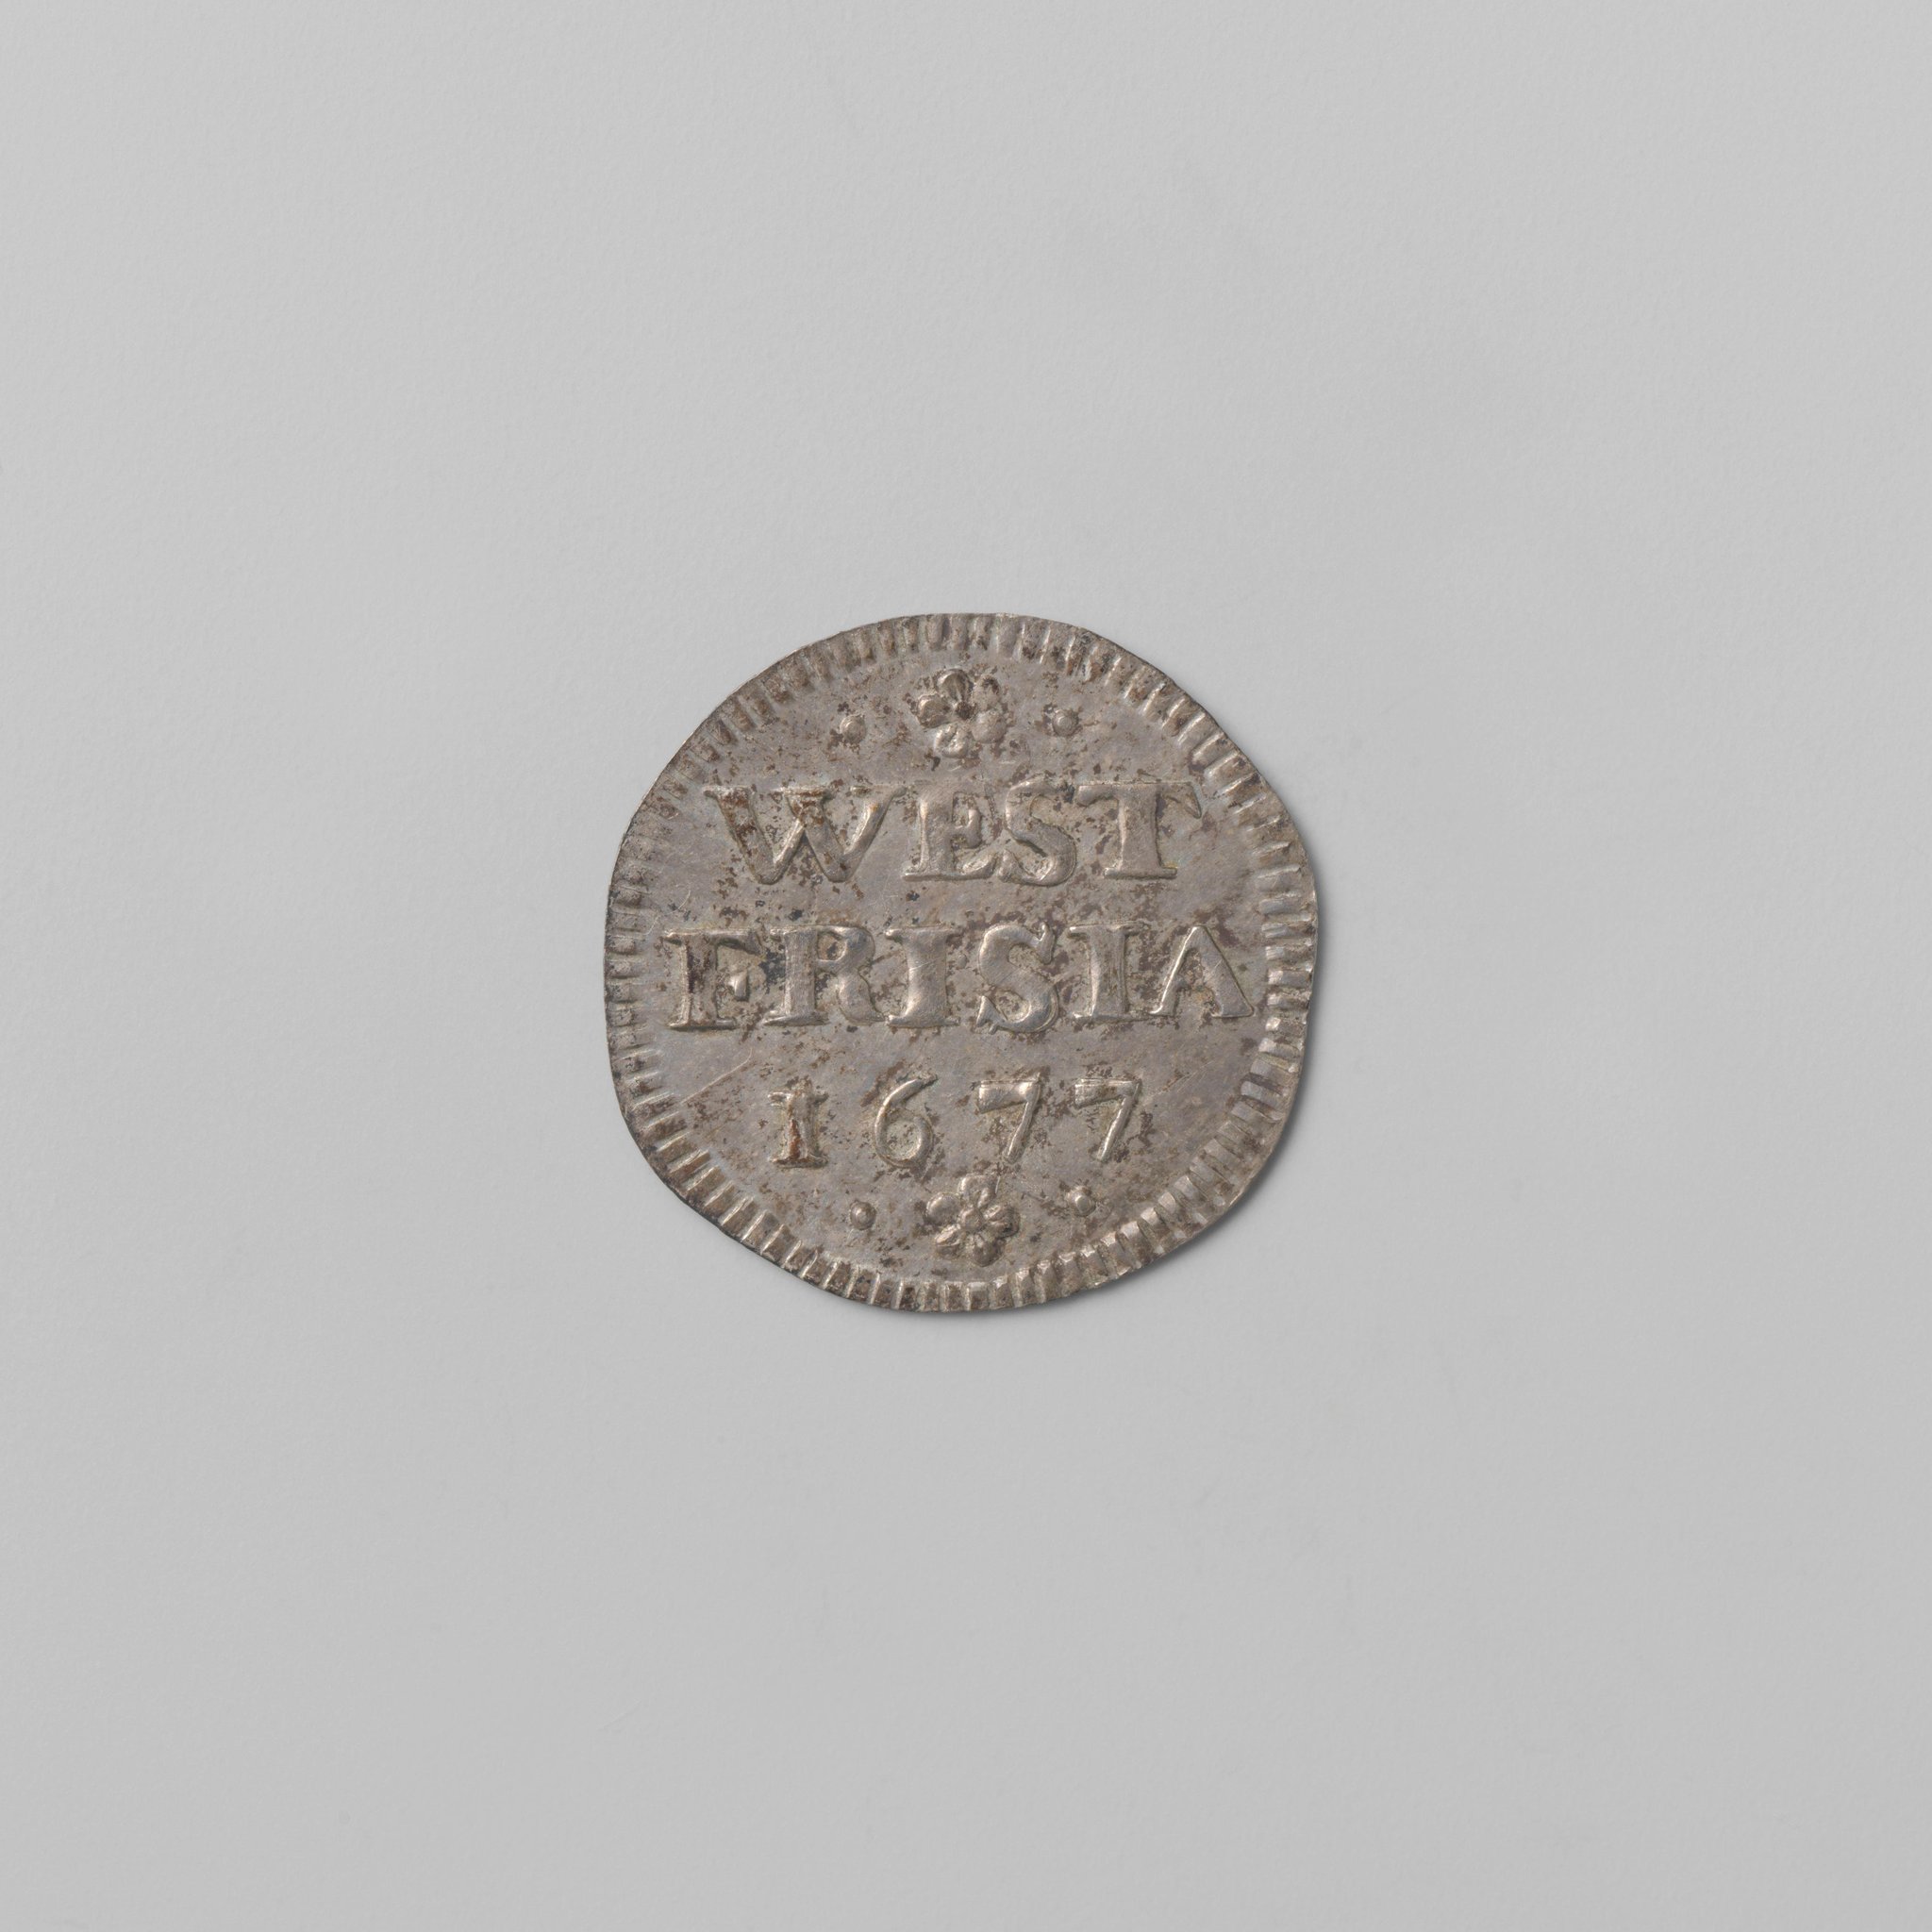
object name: coin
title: Westfriese stuiver, 1677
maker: dirck bosch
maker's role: mintmaster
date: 1677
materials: silver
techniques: striking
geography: enkhuizen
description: Zilveren munt. Voorzijde: tussen waarde-aanduiding 1 S gekroond wapenschild van West-Friesland. Keerzijde: Opschrift in twee regels.Daaronder jaartal en een rozet tussen twee punten. Daarboven eveneens een rozet tussen twee punten.